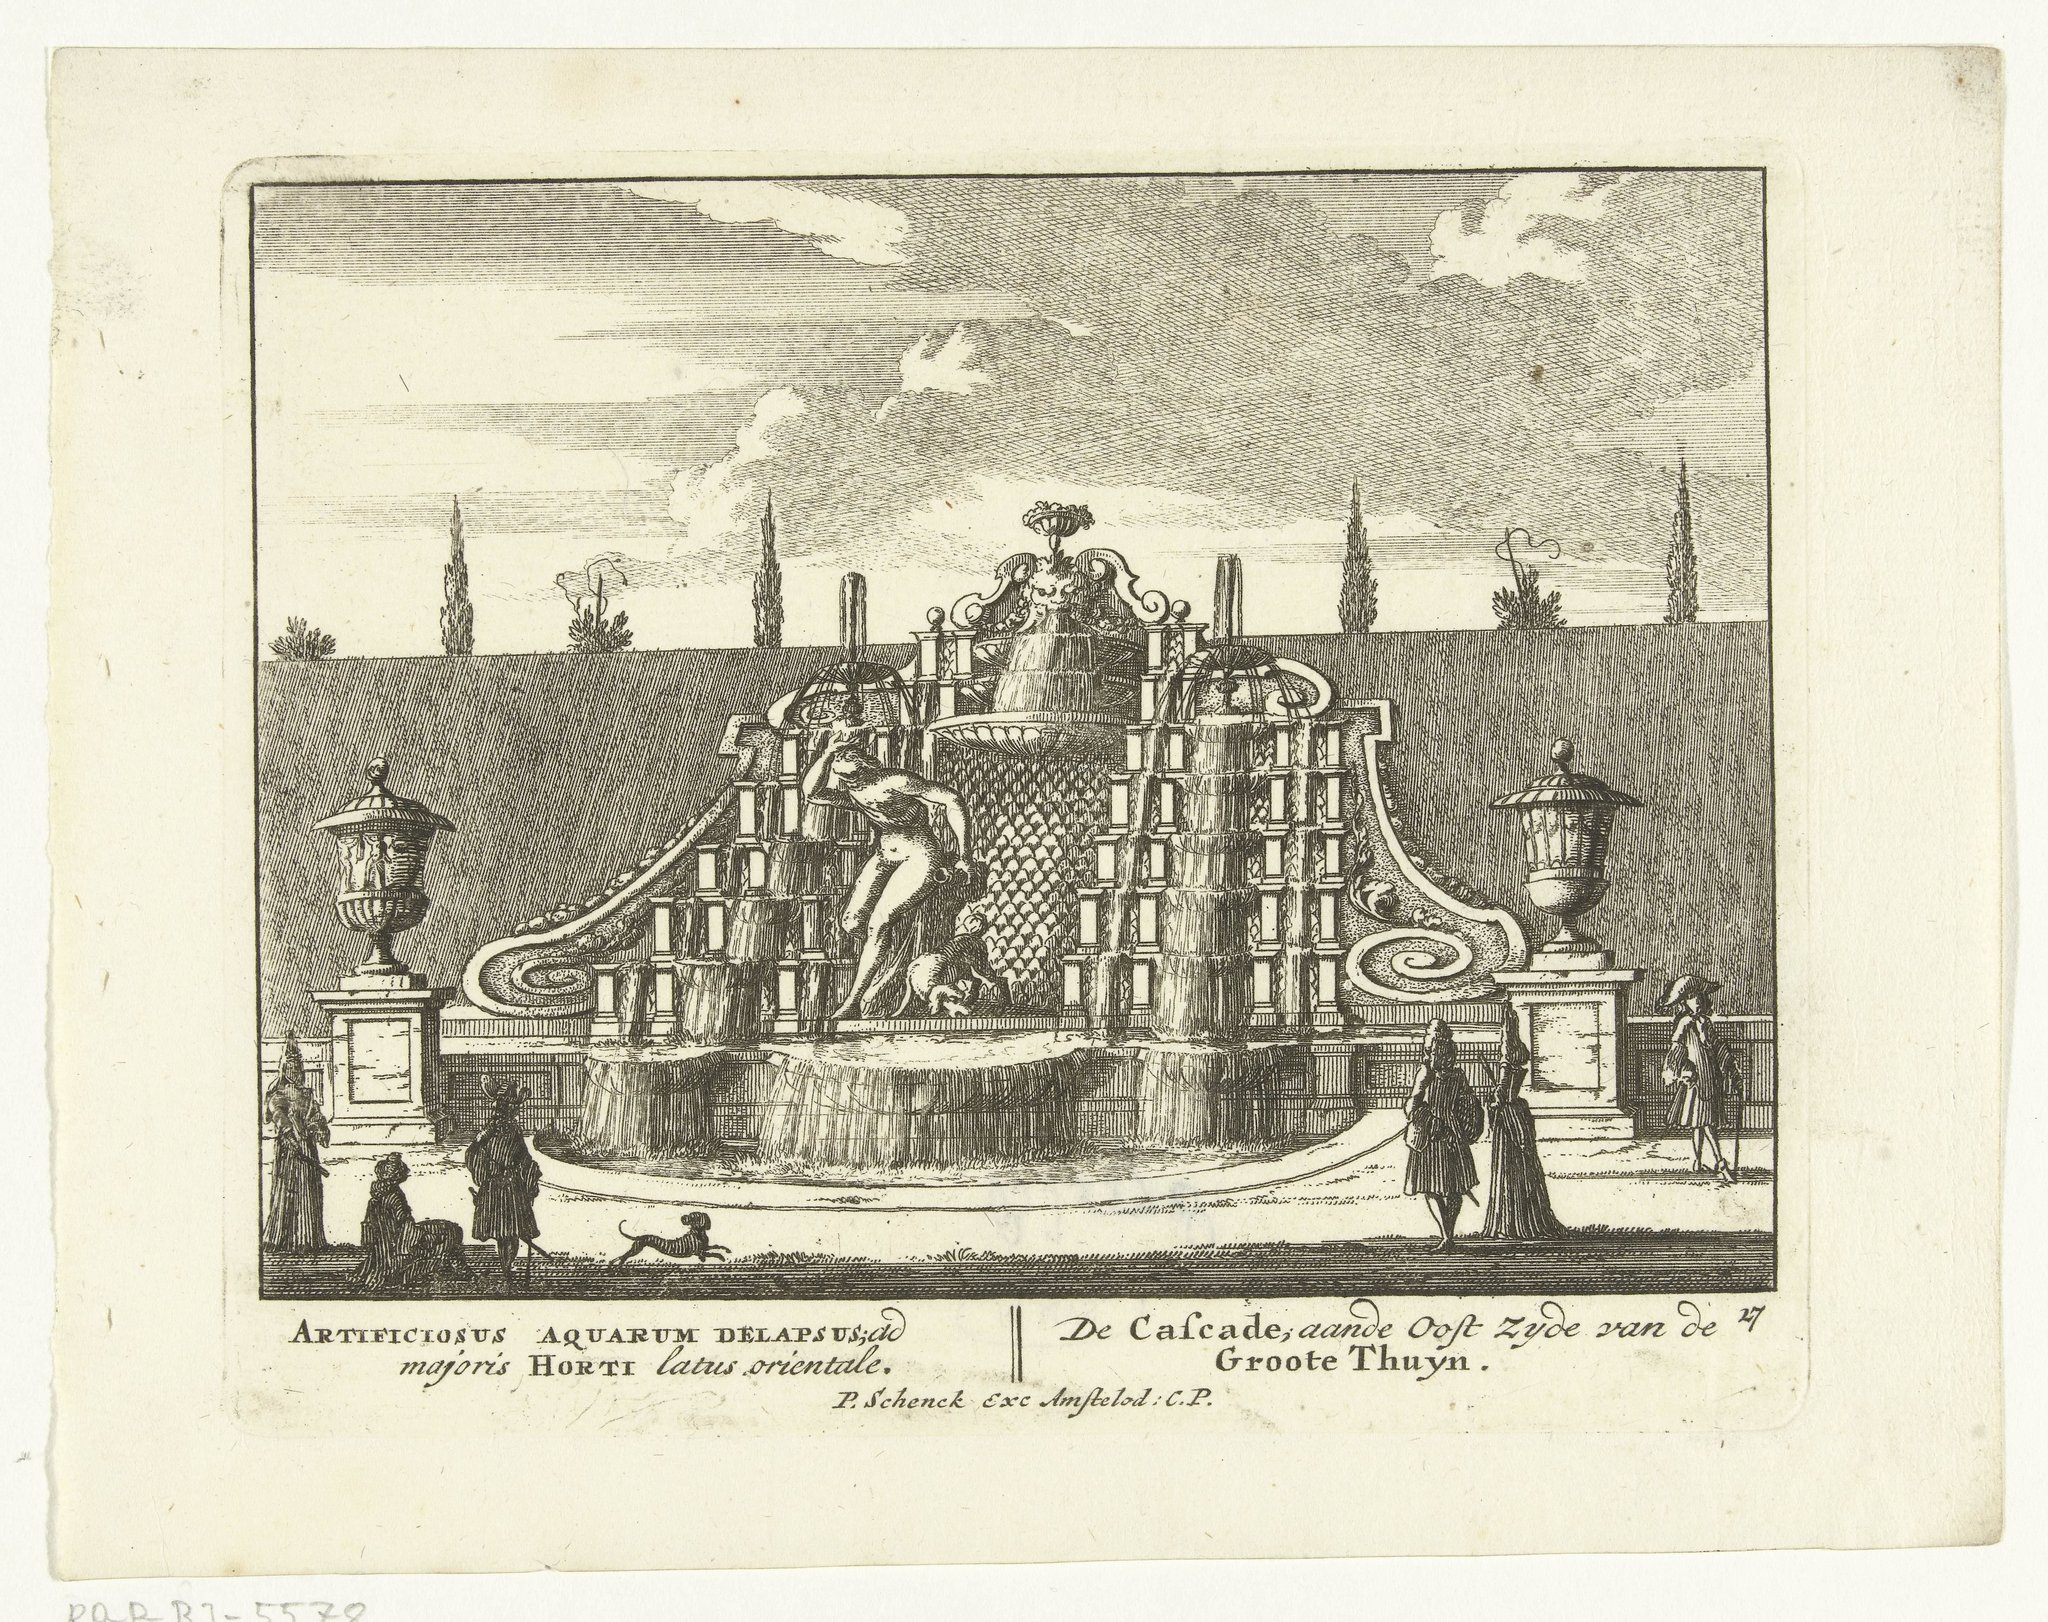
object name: print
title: Admirandorum quadruplex spectaculum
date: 1695-1705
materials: paper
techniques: etching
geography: amsterdam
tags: garden fountain, french or architectonic garden; formal garden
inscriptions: collector's mark: Lugt 2228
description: Elegant geklede dames en heren verpozen zich bij de grote fontein aan de oostzijde van de grote tuin van Het Loo. Prent uit een serie van 71 prenten met Rijnlandschappen, gezichten op vorstelijke paleizen en stadsgezichten uit Den Haag en Amsterdam.